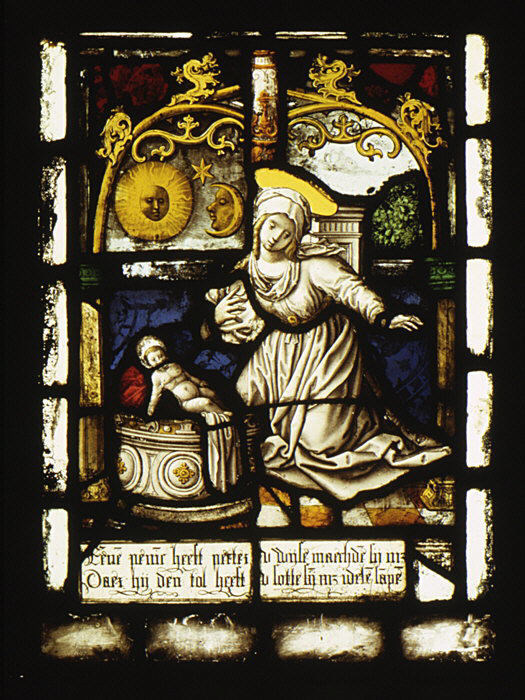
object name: panel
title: The Nativity (one of a set of 12 scenes from The Life of Christ)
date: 1525-1530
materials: glass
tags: madonna and child,nativity